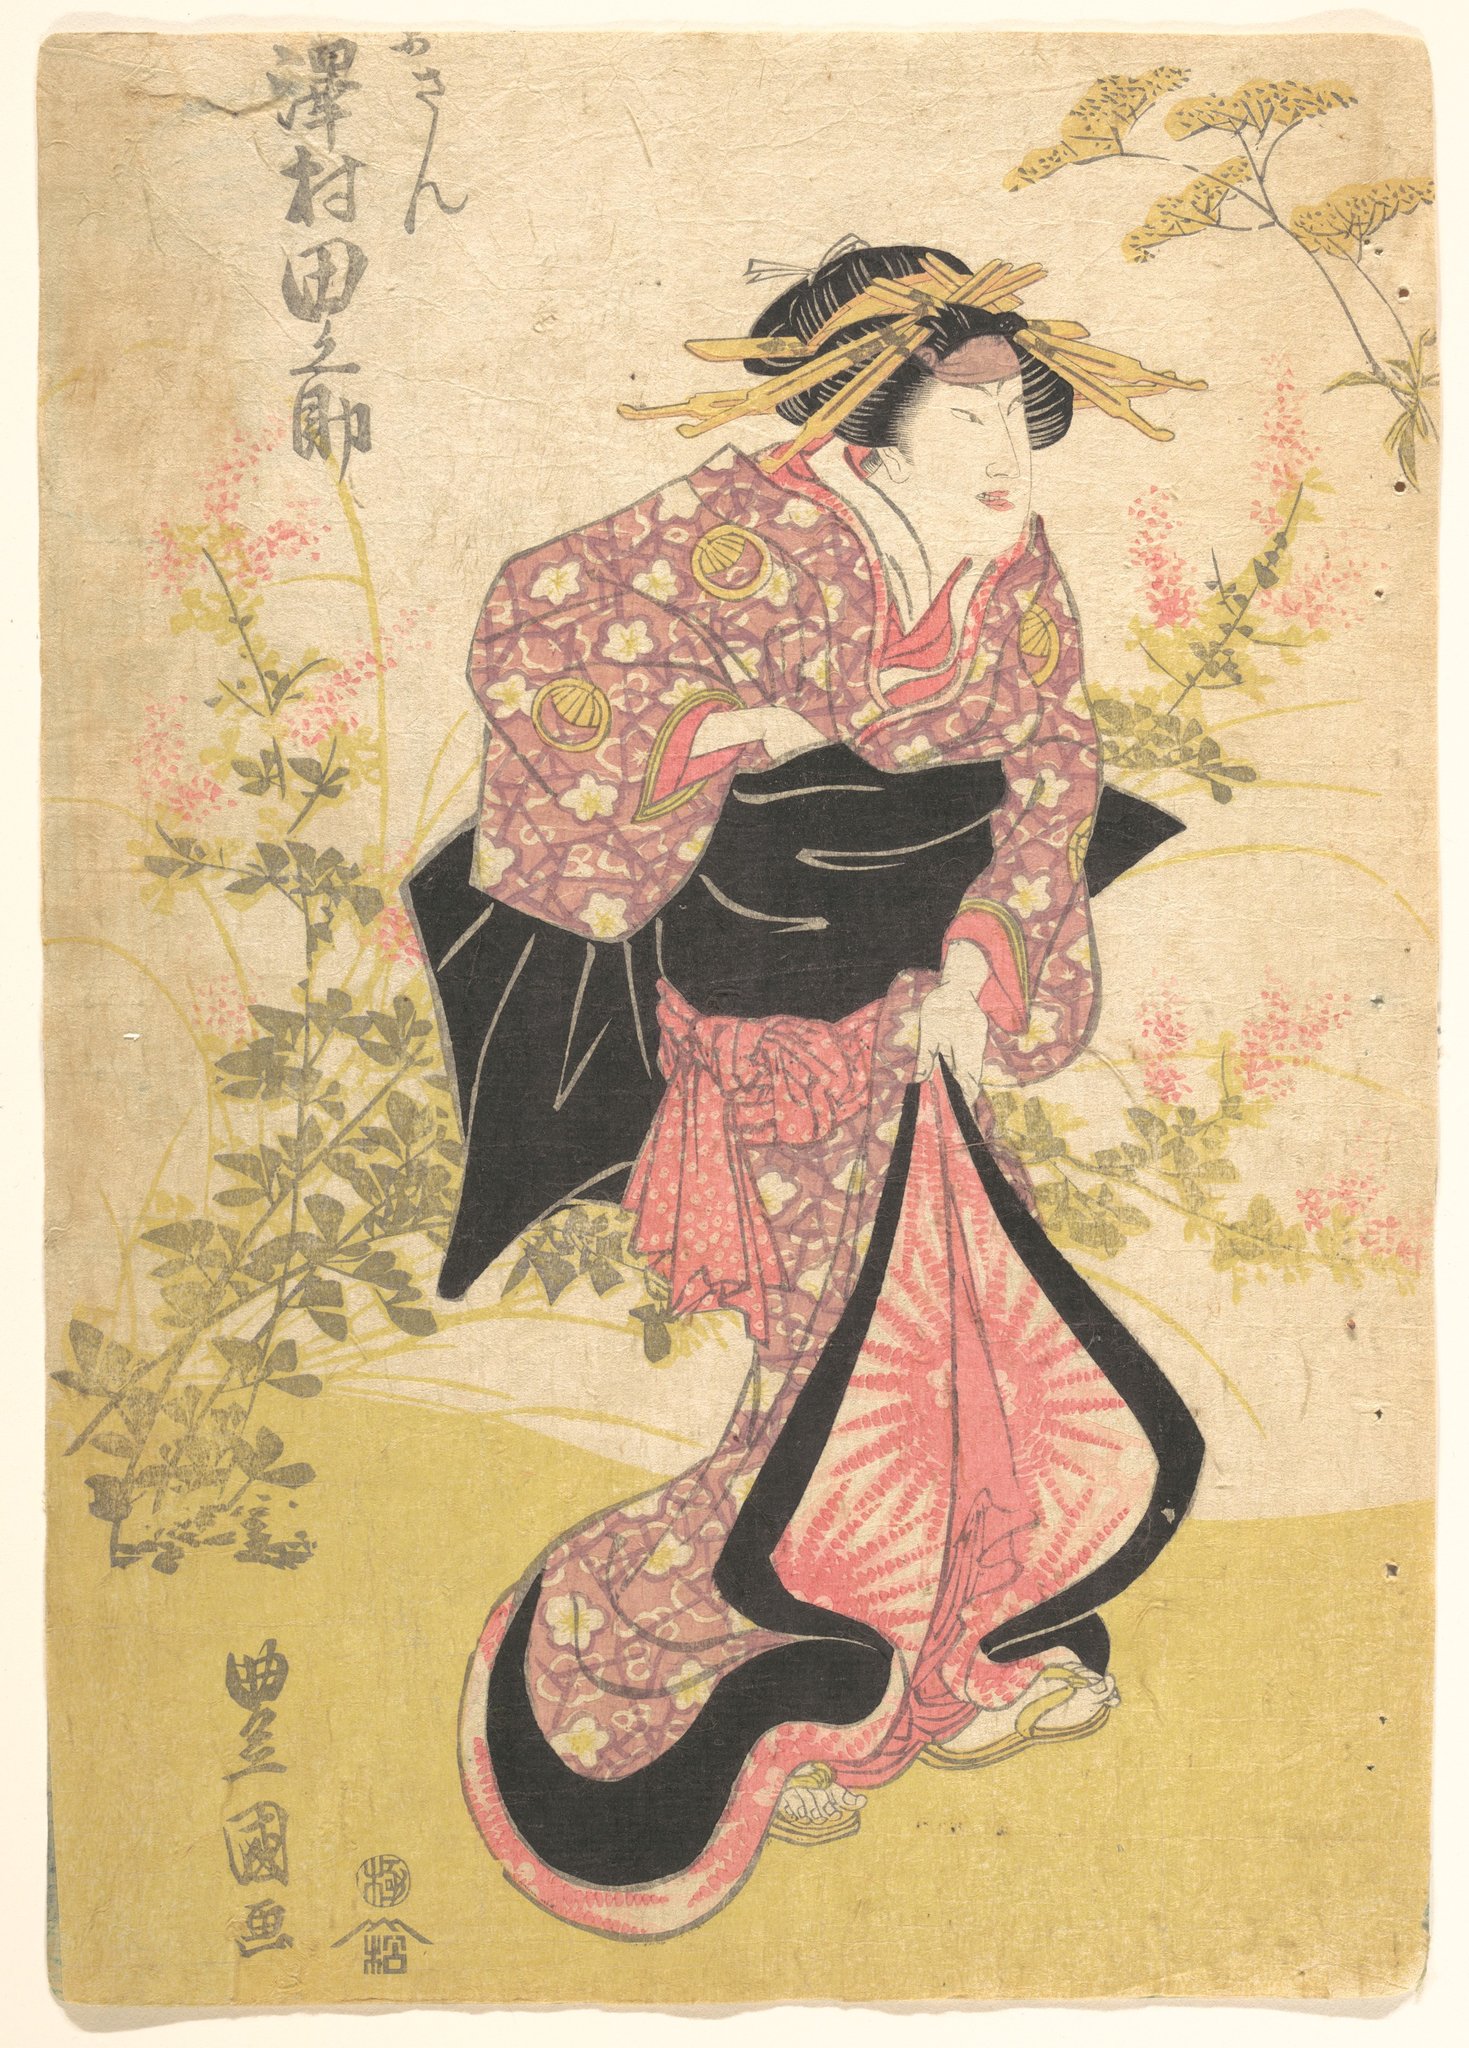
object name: print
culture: japanese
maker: utagawa kunisada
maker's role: artist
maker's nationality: japanese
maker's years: 1786-1864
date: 1801-1900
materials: ink, paper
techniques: woodblock print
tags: women